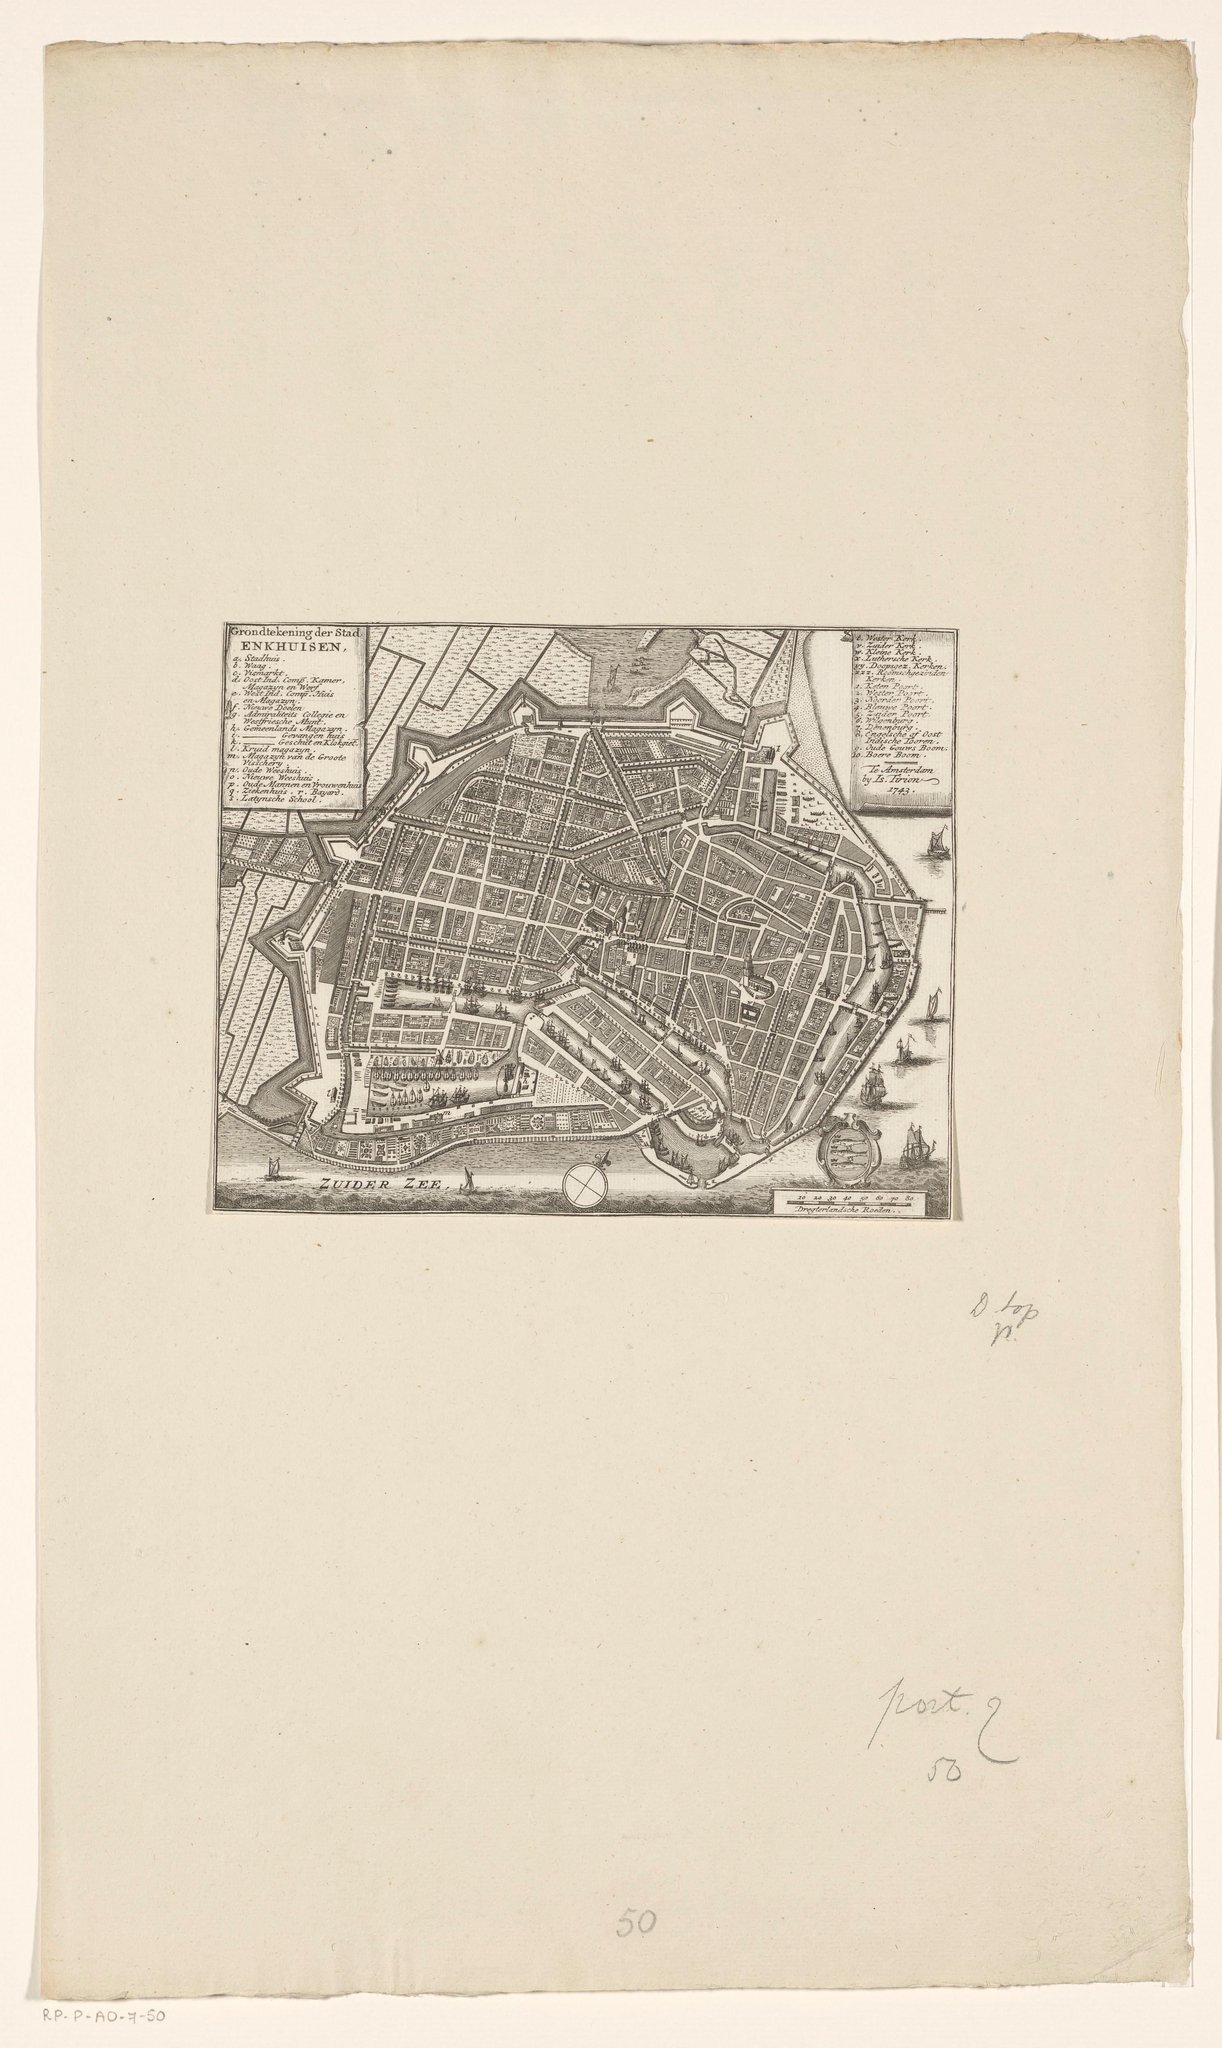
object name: book illustration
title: Grondtekening der stad Enkhuisen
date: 1743-1744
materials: paper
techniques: engraving, etching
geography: amsterdam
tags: coat of arms (as symbol of the state, etc.) (+ city; municipal), maps of cities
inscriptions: collector's mark: Lugt 195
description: Prent ook gebruikt in: Wagenaar, Jan. Tegenwoordige staat der Vereenigde Nederlanden, vyfde deel. Behelzende het vervolg der beschrijvinge van Holland. Met naauwkeurige plans der steden en printverbeeldingen versierd / Hedendaagsche historie, of tegenwoordige staat van alle volkeren; XVde deel (…). Amsterdam: Isaak Tirion, 1744, tussen p. 448 en 449. Latere staat van prent ook gebruikt in: Beknopte atlas, van omtrent honderd platte gronden der voornaamste vestingen, kasteelen en steden van Europa, en byzonder van de Nederlanden en eenige kolonien (…). Amsterdam: Compagnie van Boekverkopers, s.a. [na 1780].